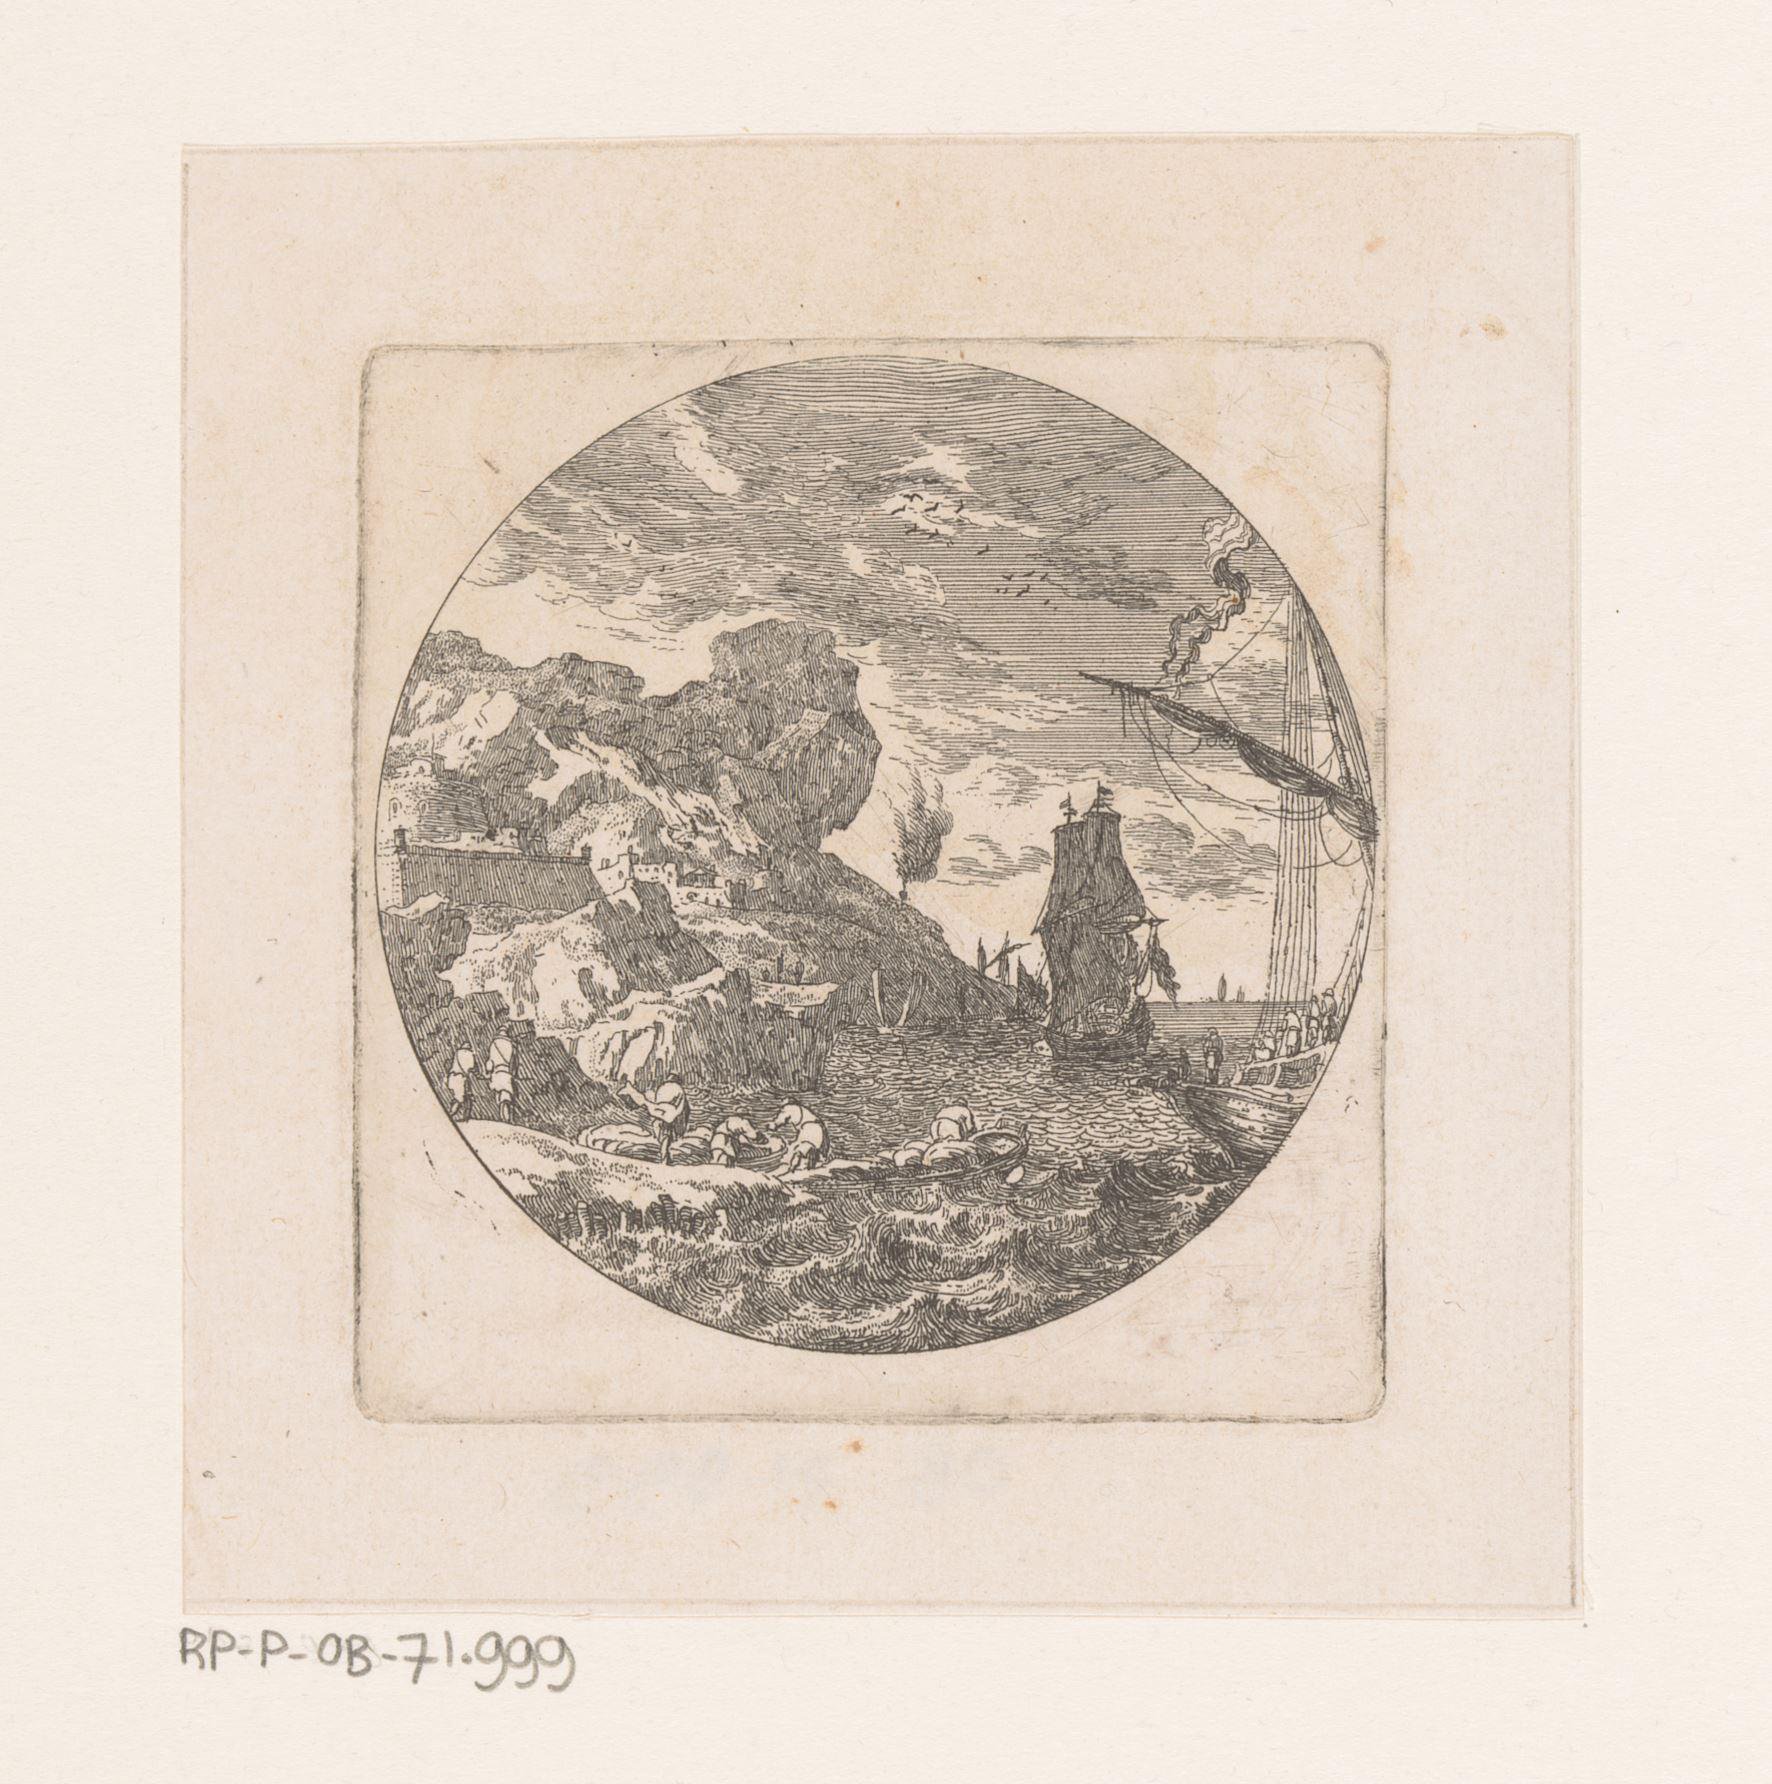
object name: print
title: Gezicht op schepen bij kust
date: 1613-1695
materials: paper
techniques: etching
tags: harbour, coast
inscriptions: collector's mark: Lugt 240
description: Prenten met het signatuur 'Perelle' kunnen zowel door vader Gabriel als door zonen Nicolas en Adam gemaakt zijn.